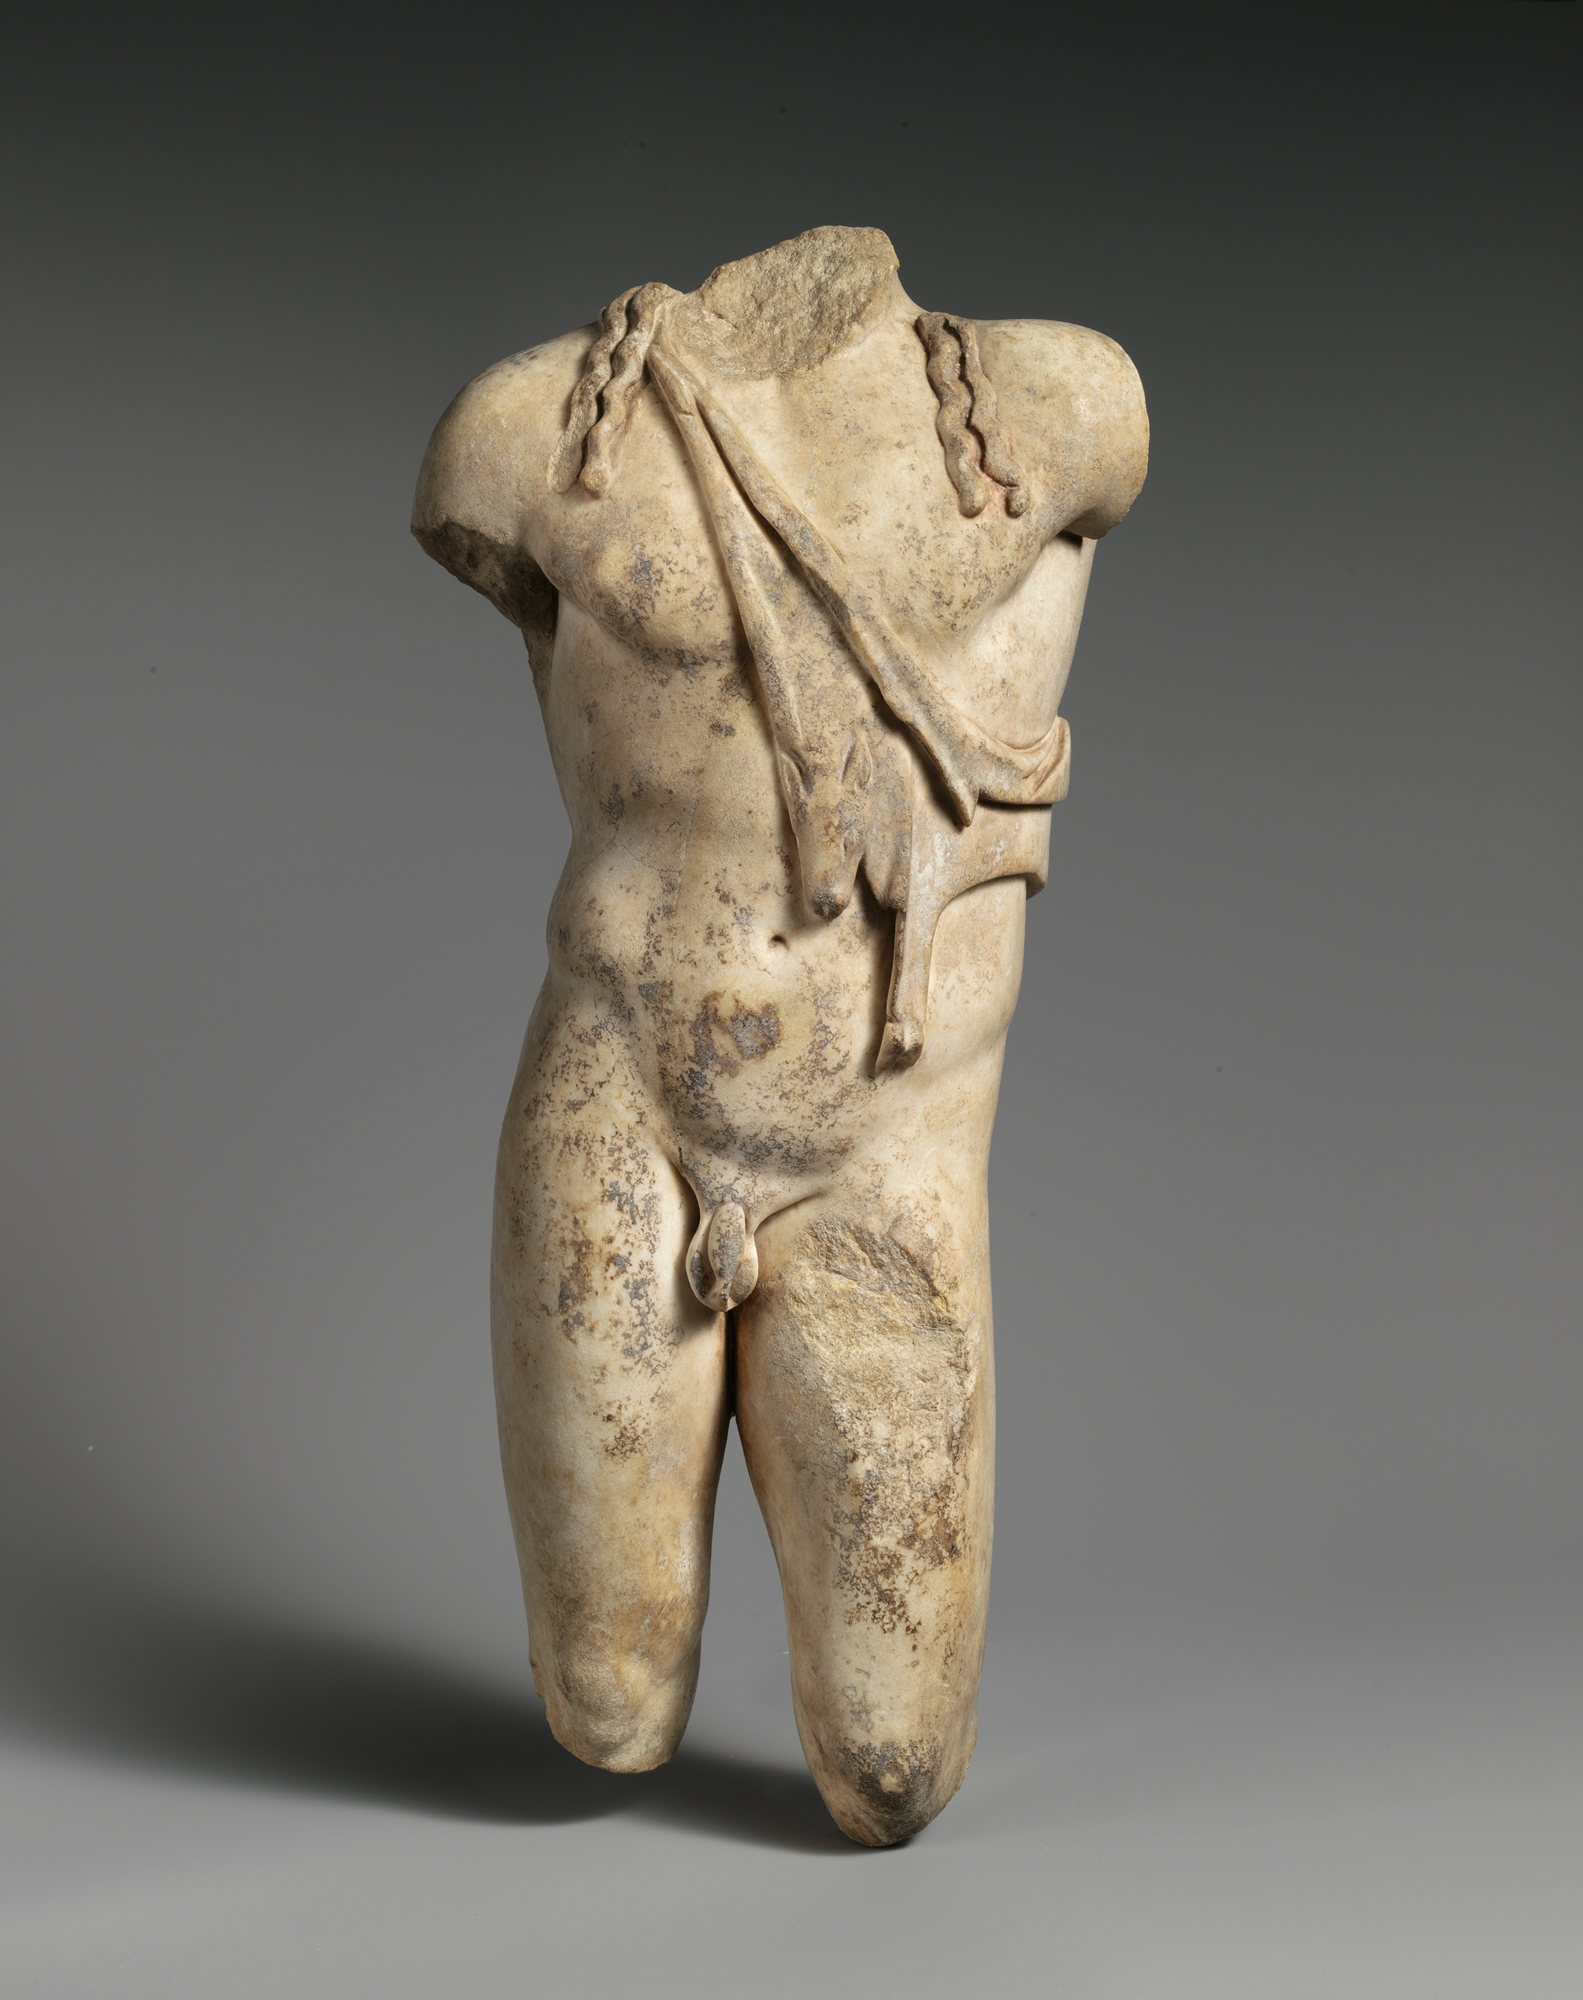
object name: torso of dionysos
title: Marble statuette of young Dionysos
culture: roman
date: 1-200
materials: marble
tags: male nudes,dionysus